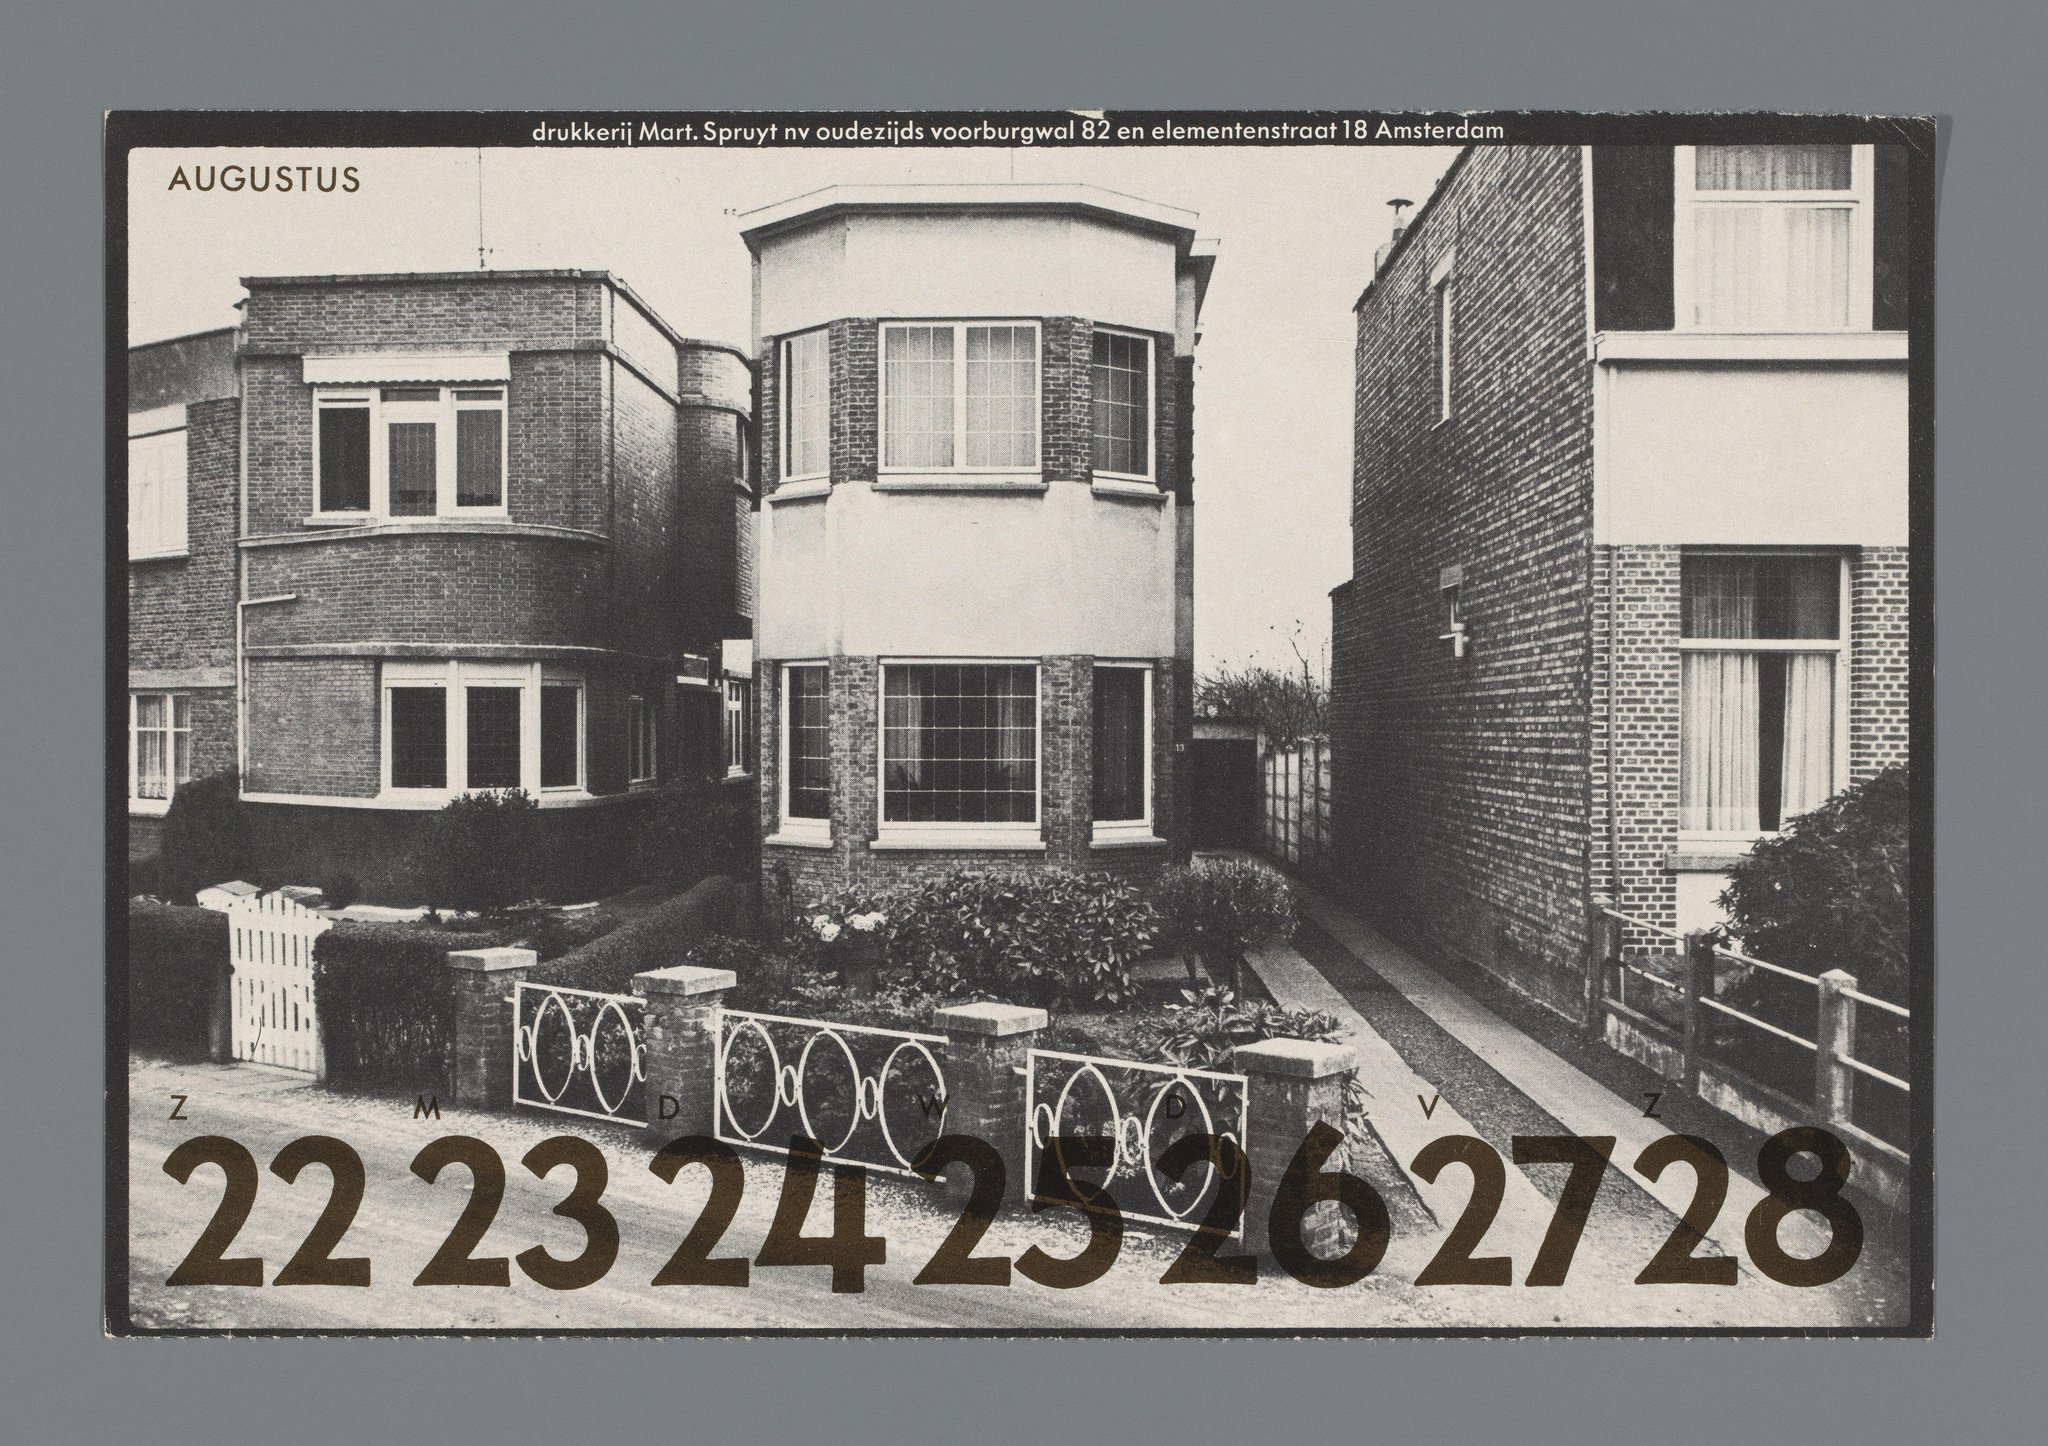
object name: photograph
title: België. Huizen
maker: Anonymous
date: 1900-1950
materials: paper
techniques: offset printed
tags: belgium